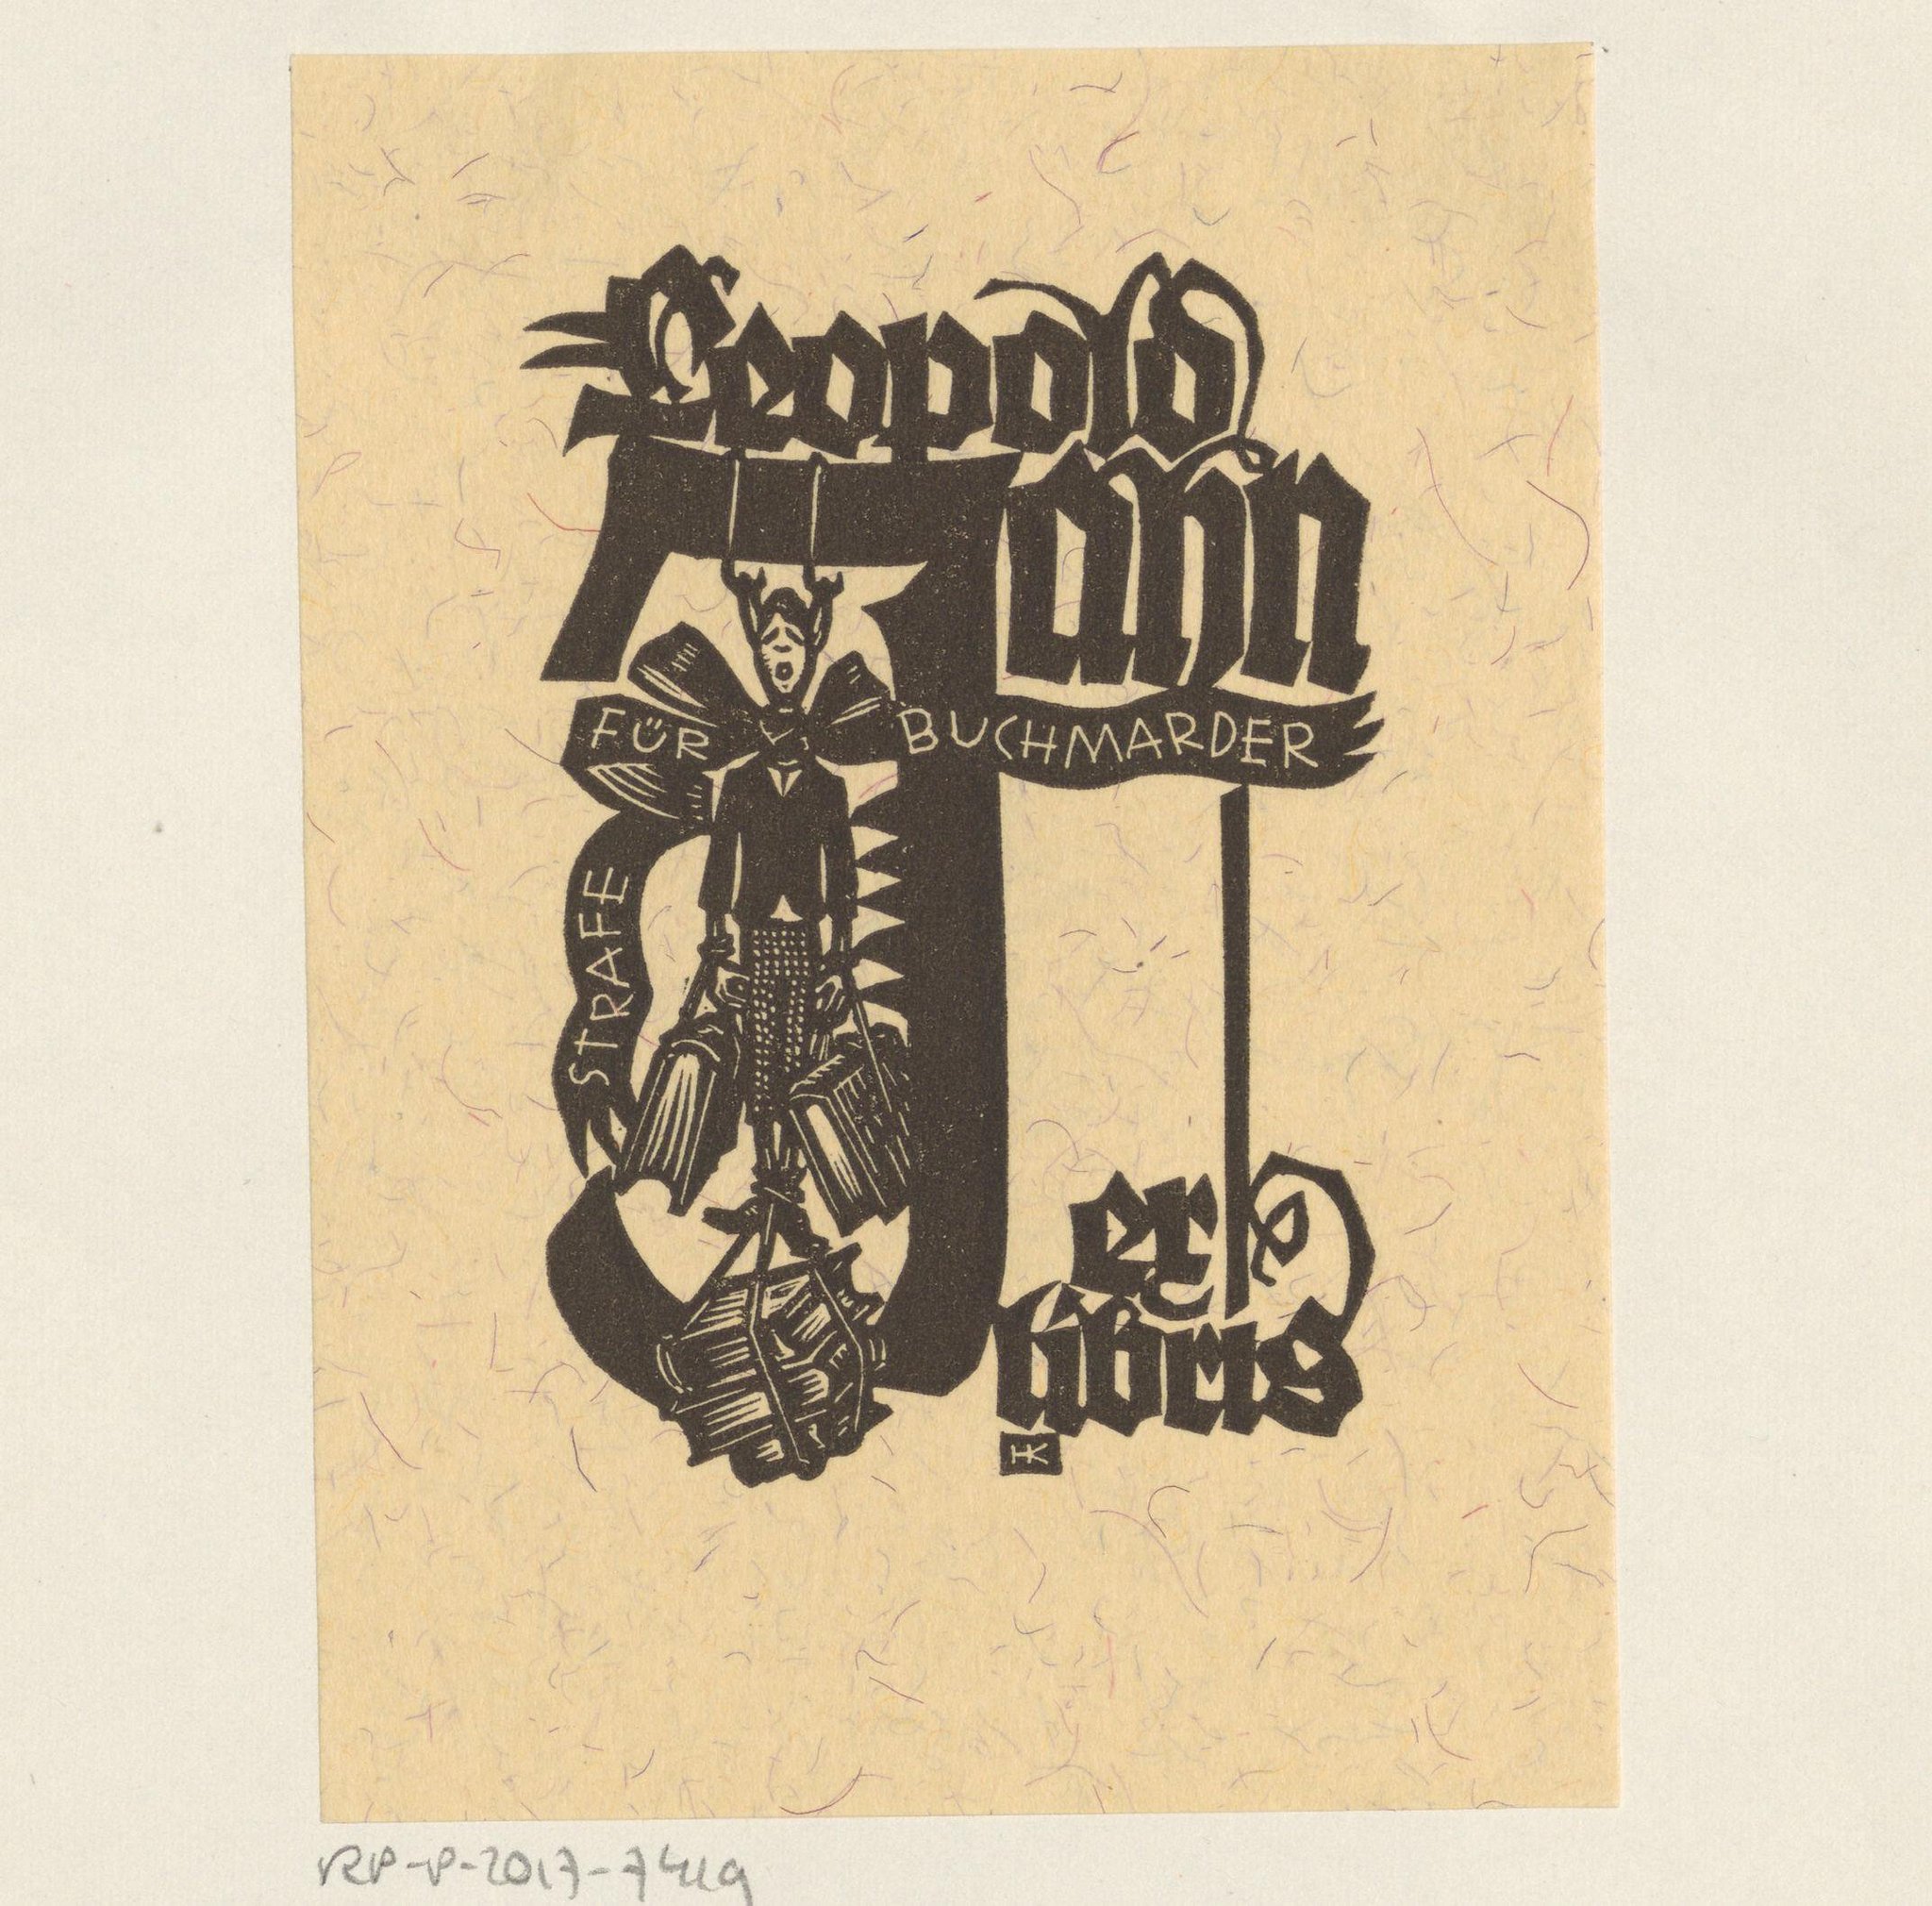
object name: bookplate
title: Strafe für Buchmarder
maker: karl haselböck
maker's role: print maker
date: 1921-1984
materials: paper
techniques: woodcut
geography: austria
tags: vienna, painter, violent death by hanging, book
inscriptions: handgeschreven